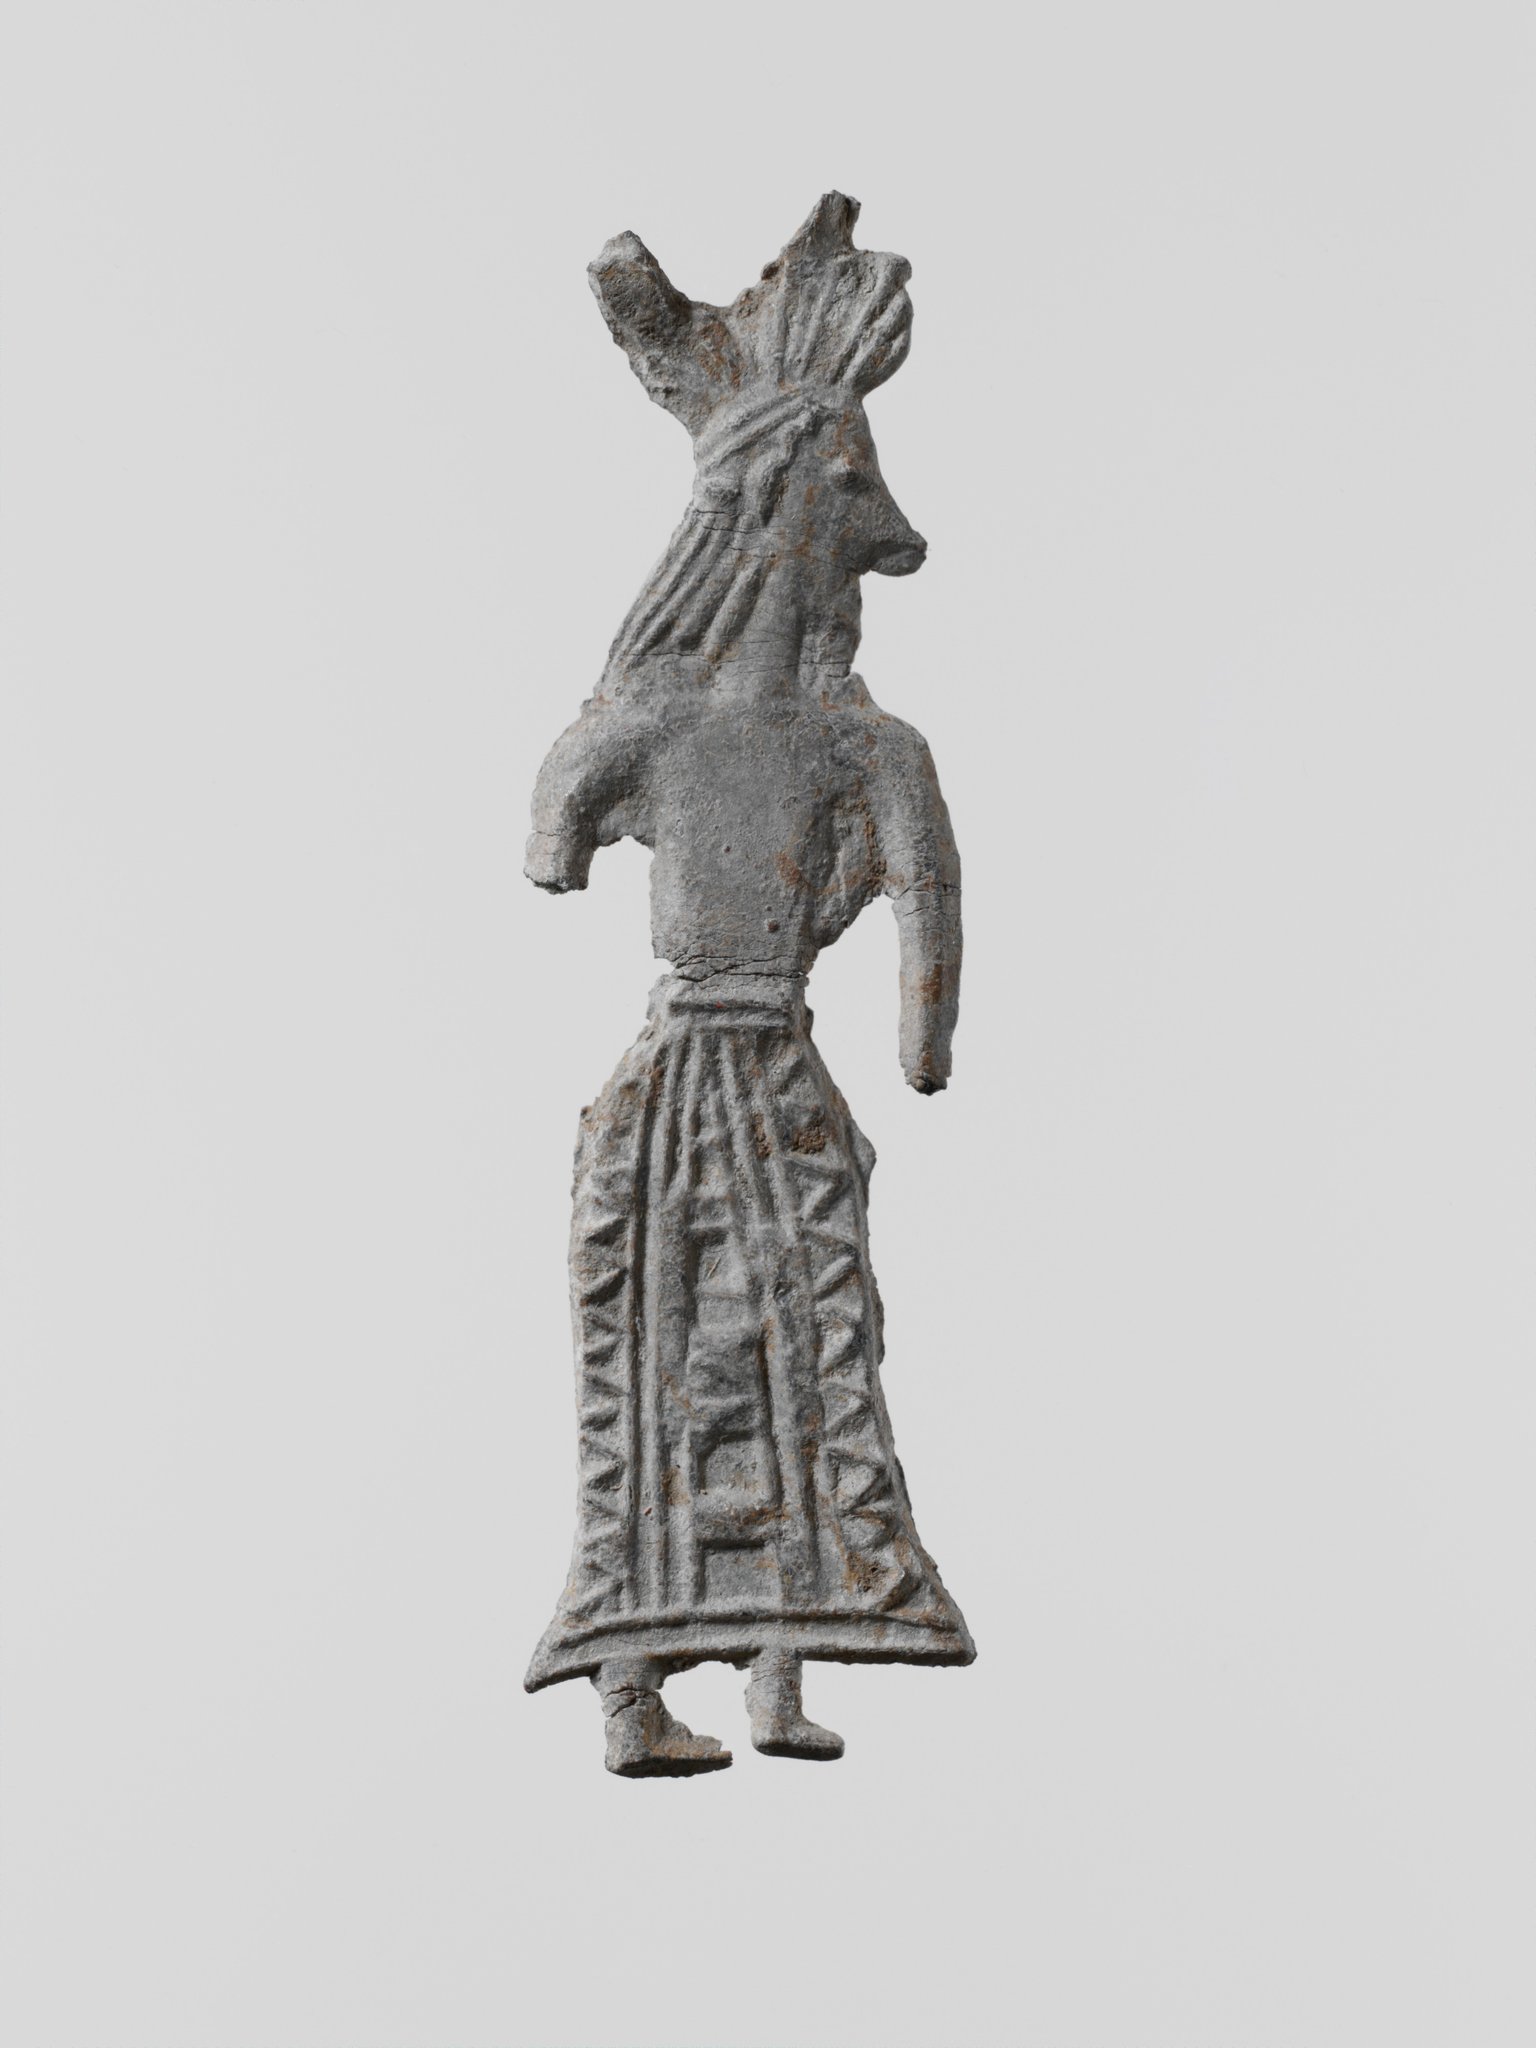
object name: statuette of a woman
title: Lead figure of a woman with wreath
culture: greek, laconian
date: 634-568 BCE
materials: lead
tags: women,wreaths